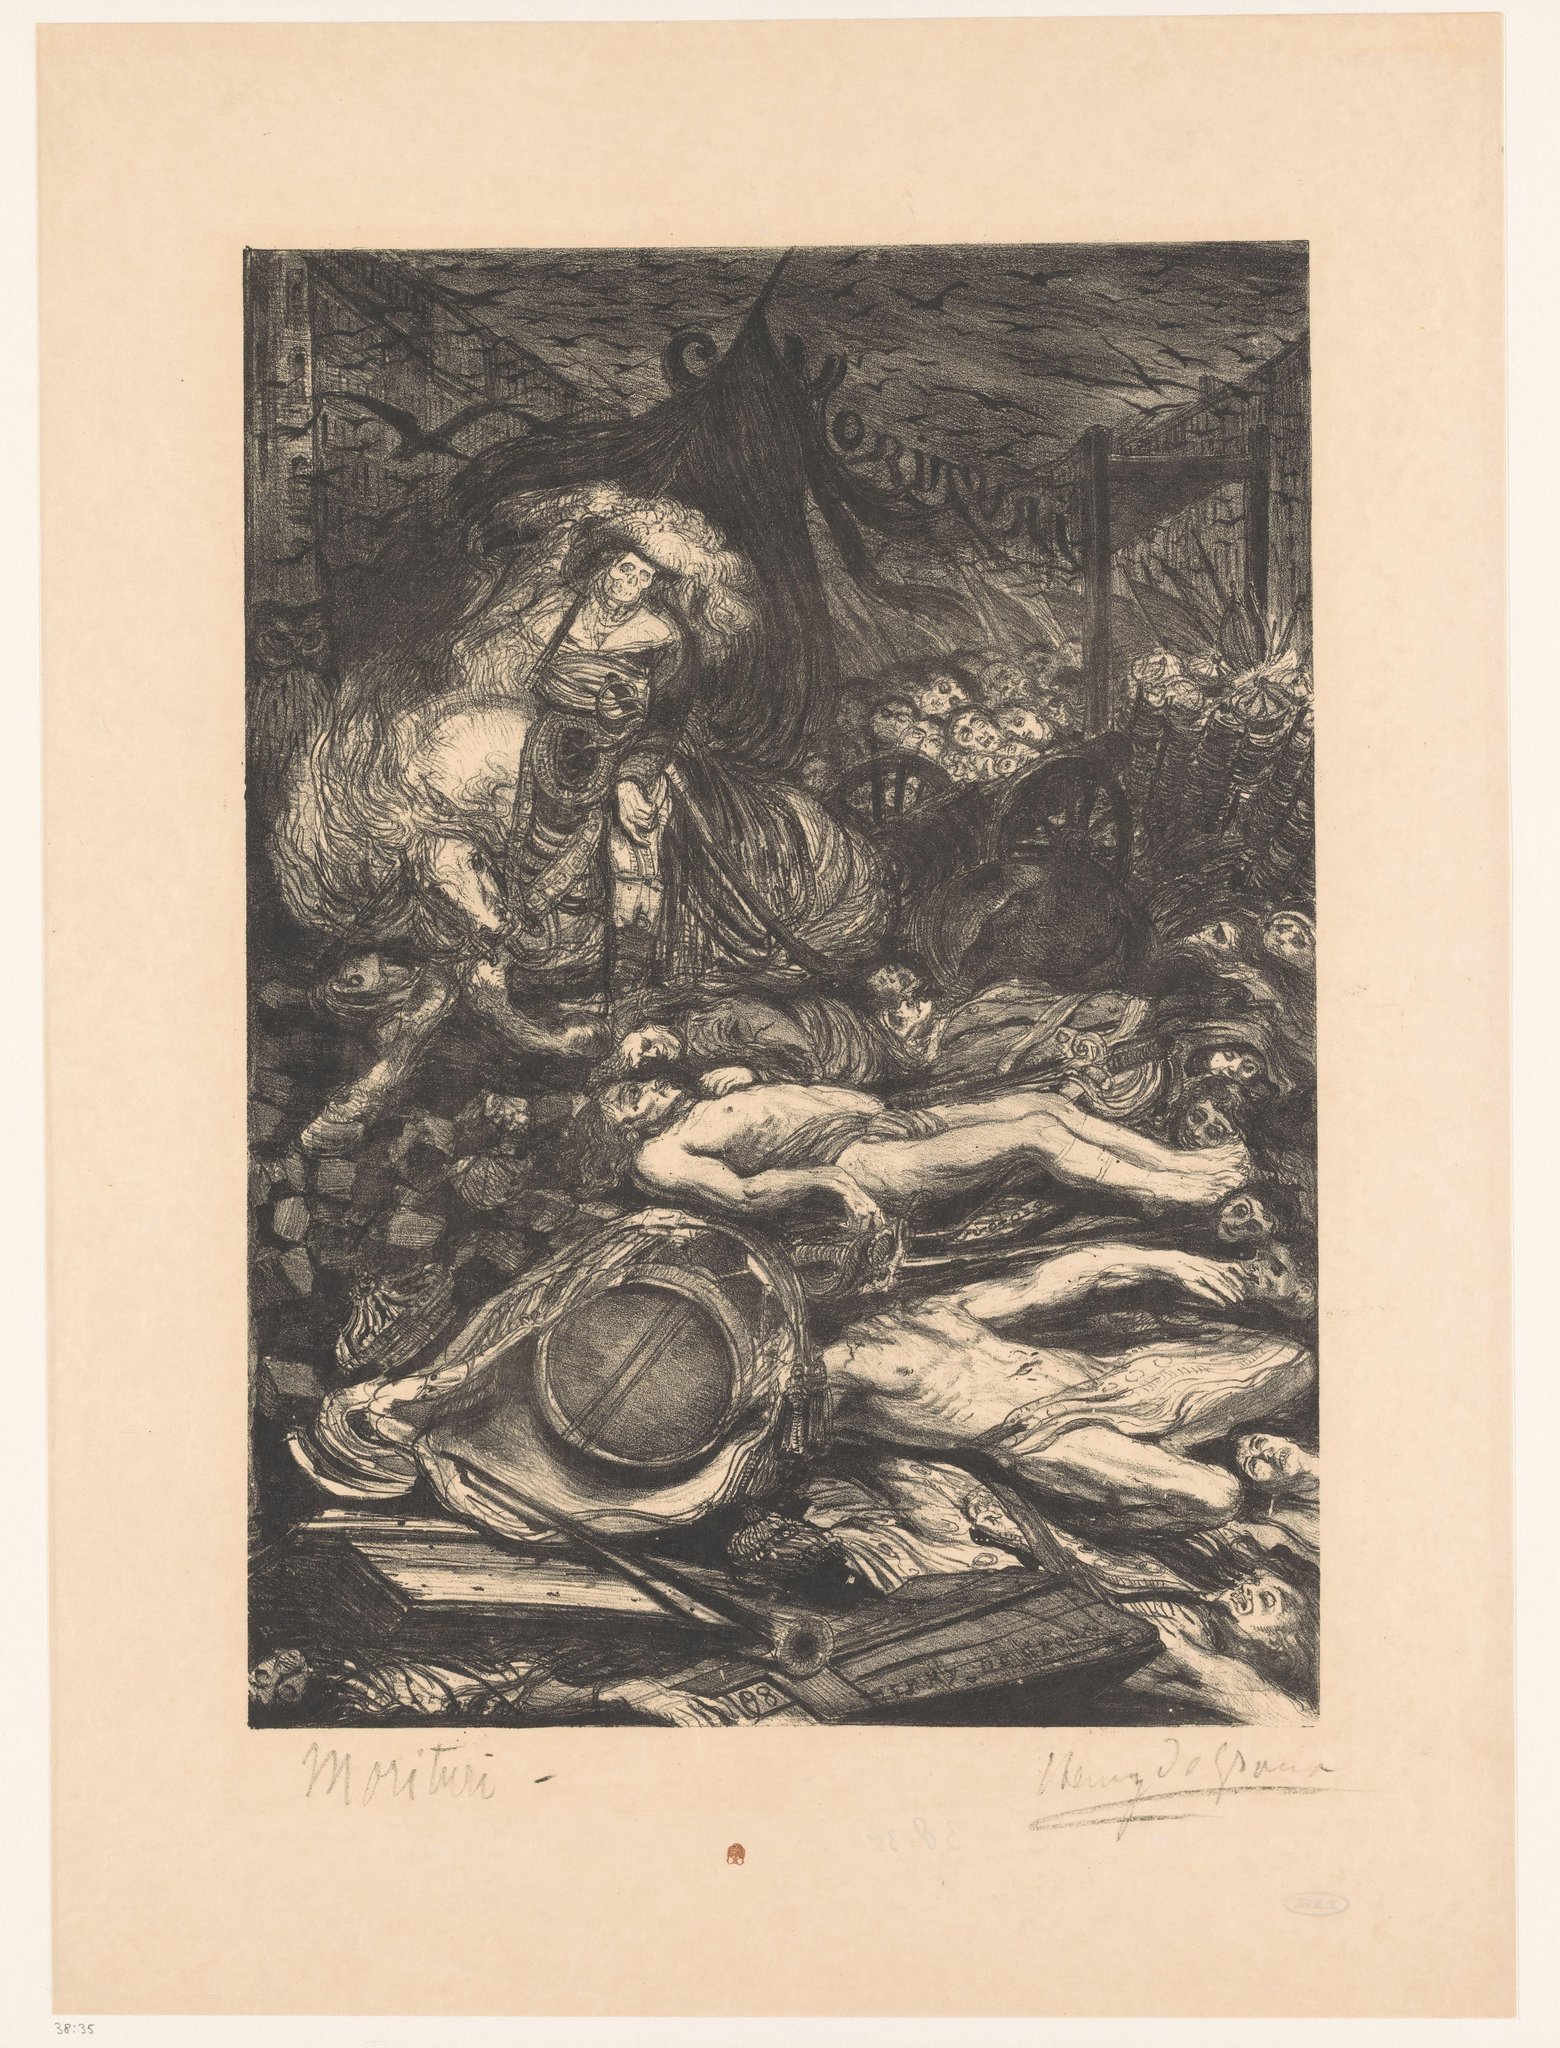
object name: print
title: Morituri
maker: henri de groux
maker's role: painter, print maker, sculptor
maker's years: 1866-1930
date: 1898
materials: paper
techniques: lithograph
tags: riding a horse, ass, or mule; rider, horseman, death as skeleton, violent death, being killed; being mishandled and maltreated; seeking death, the corpse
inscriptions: inscription: ‘Morituri’, collector's mark: Lugt 2228, collector's mark: Lugt 2760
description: Een dergelijke voorstelling als op deze prent heeft De Groux gebruikt ter illustratie van het theaterprogramma voor het stuk Morituri van Romain Rolland (Théâtre de l'Oeuvre, 18 May 1898).